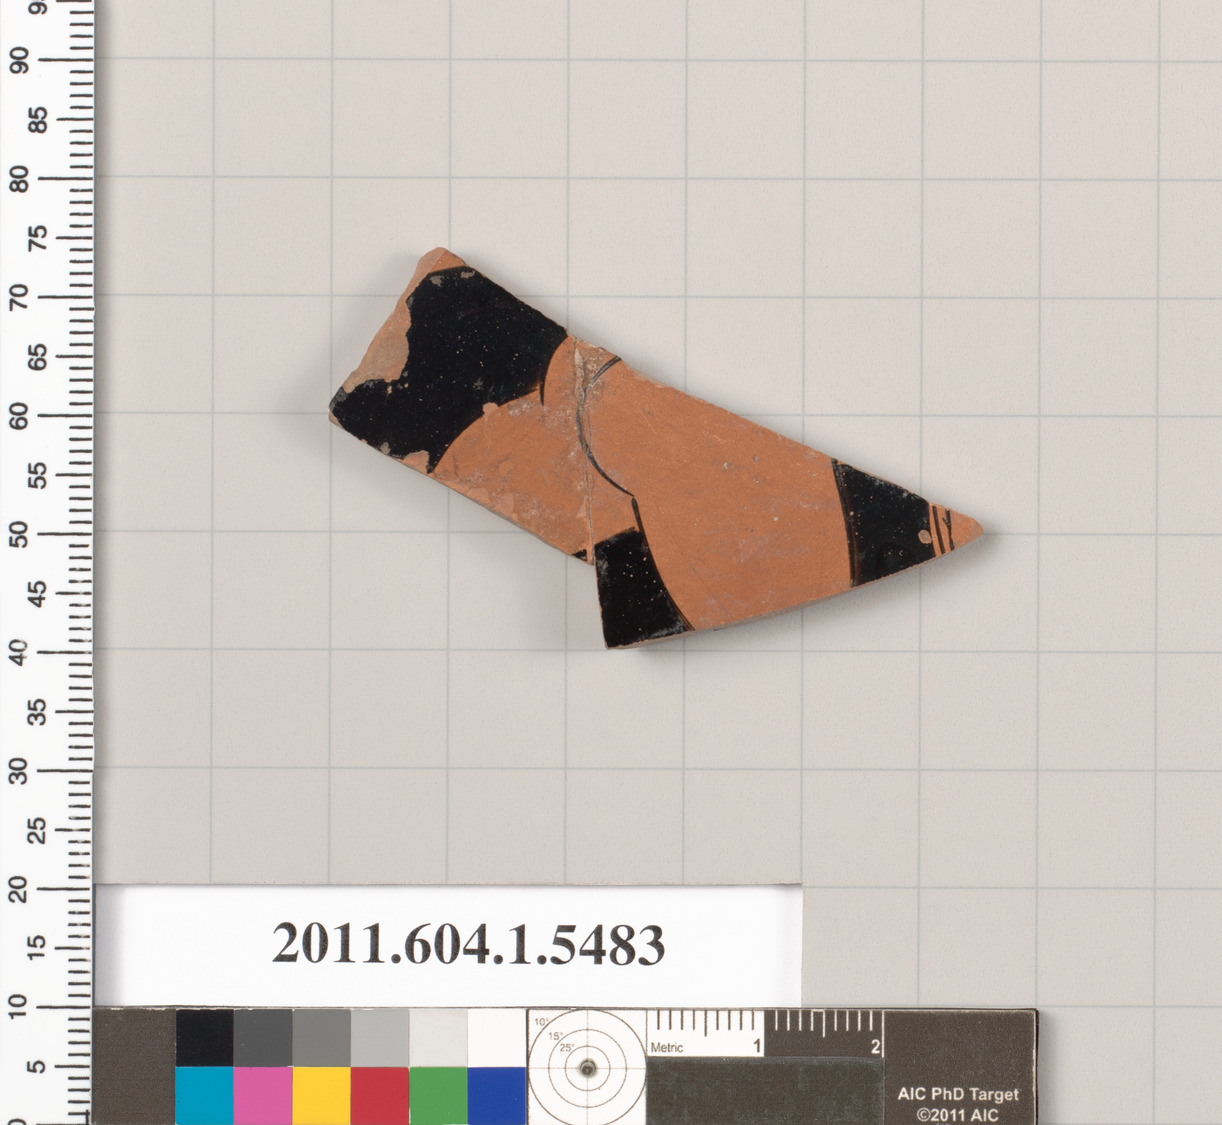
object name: kylix fragment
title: Terracotta fragment of a kylix (drinking cup)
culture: greek, attic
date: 500-480 BCE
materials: terracotta